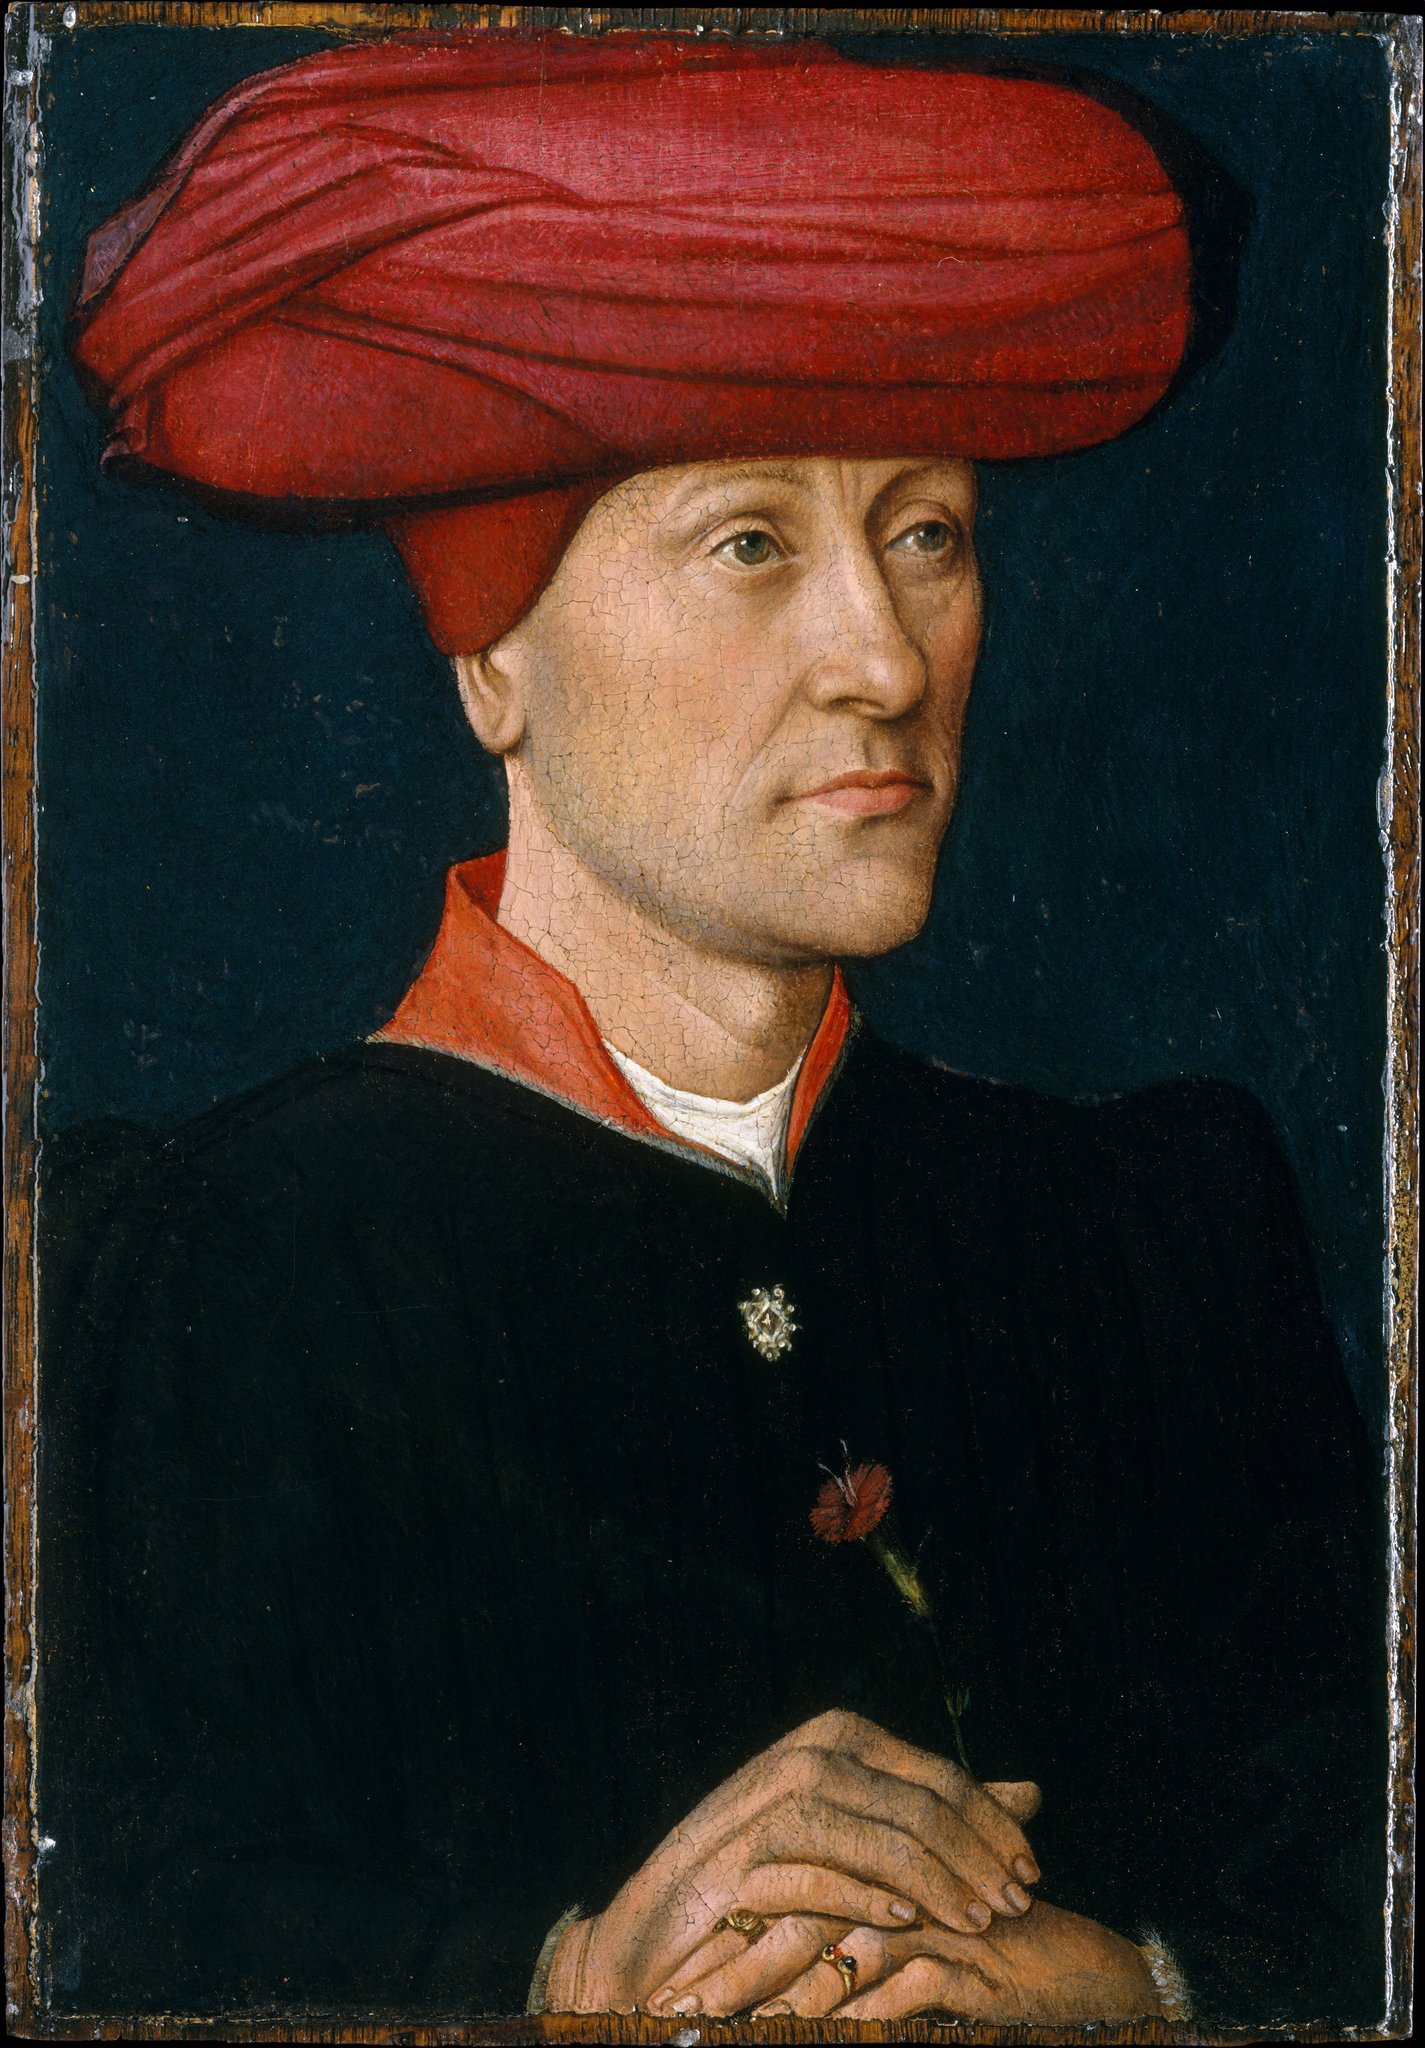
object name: painting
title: Portrait of a Man in a Chaperon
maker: netherlandish painter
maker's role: artist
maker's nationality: netherlandish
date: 1440-1450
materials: oil, wood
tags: men,portraits